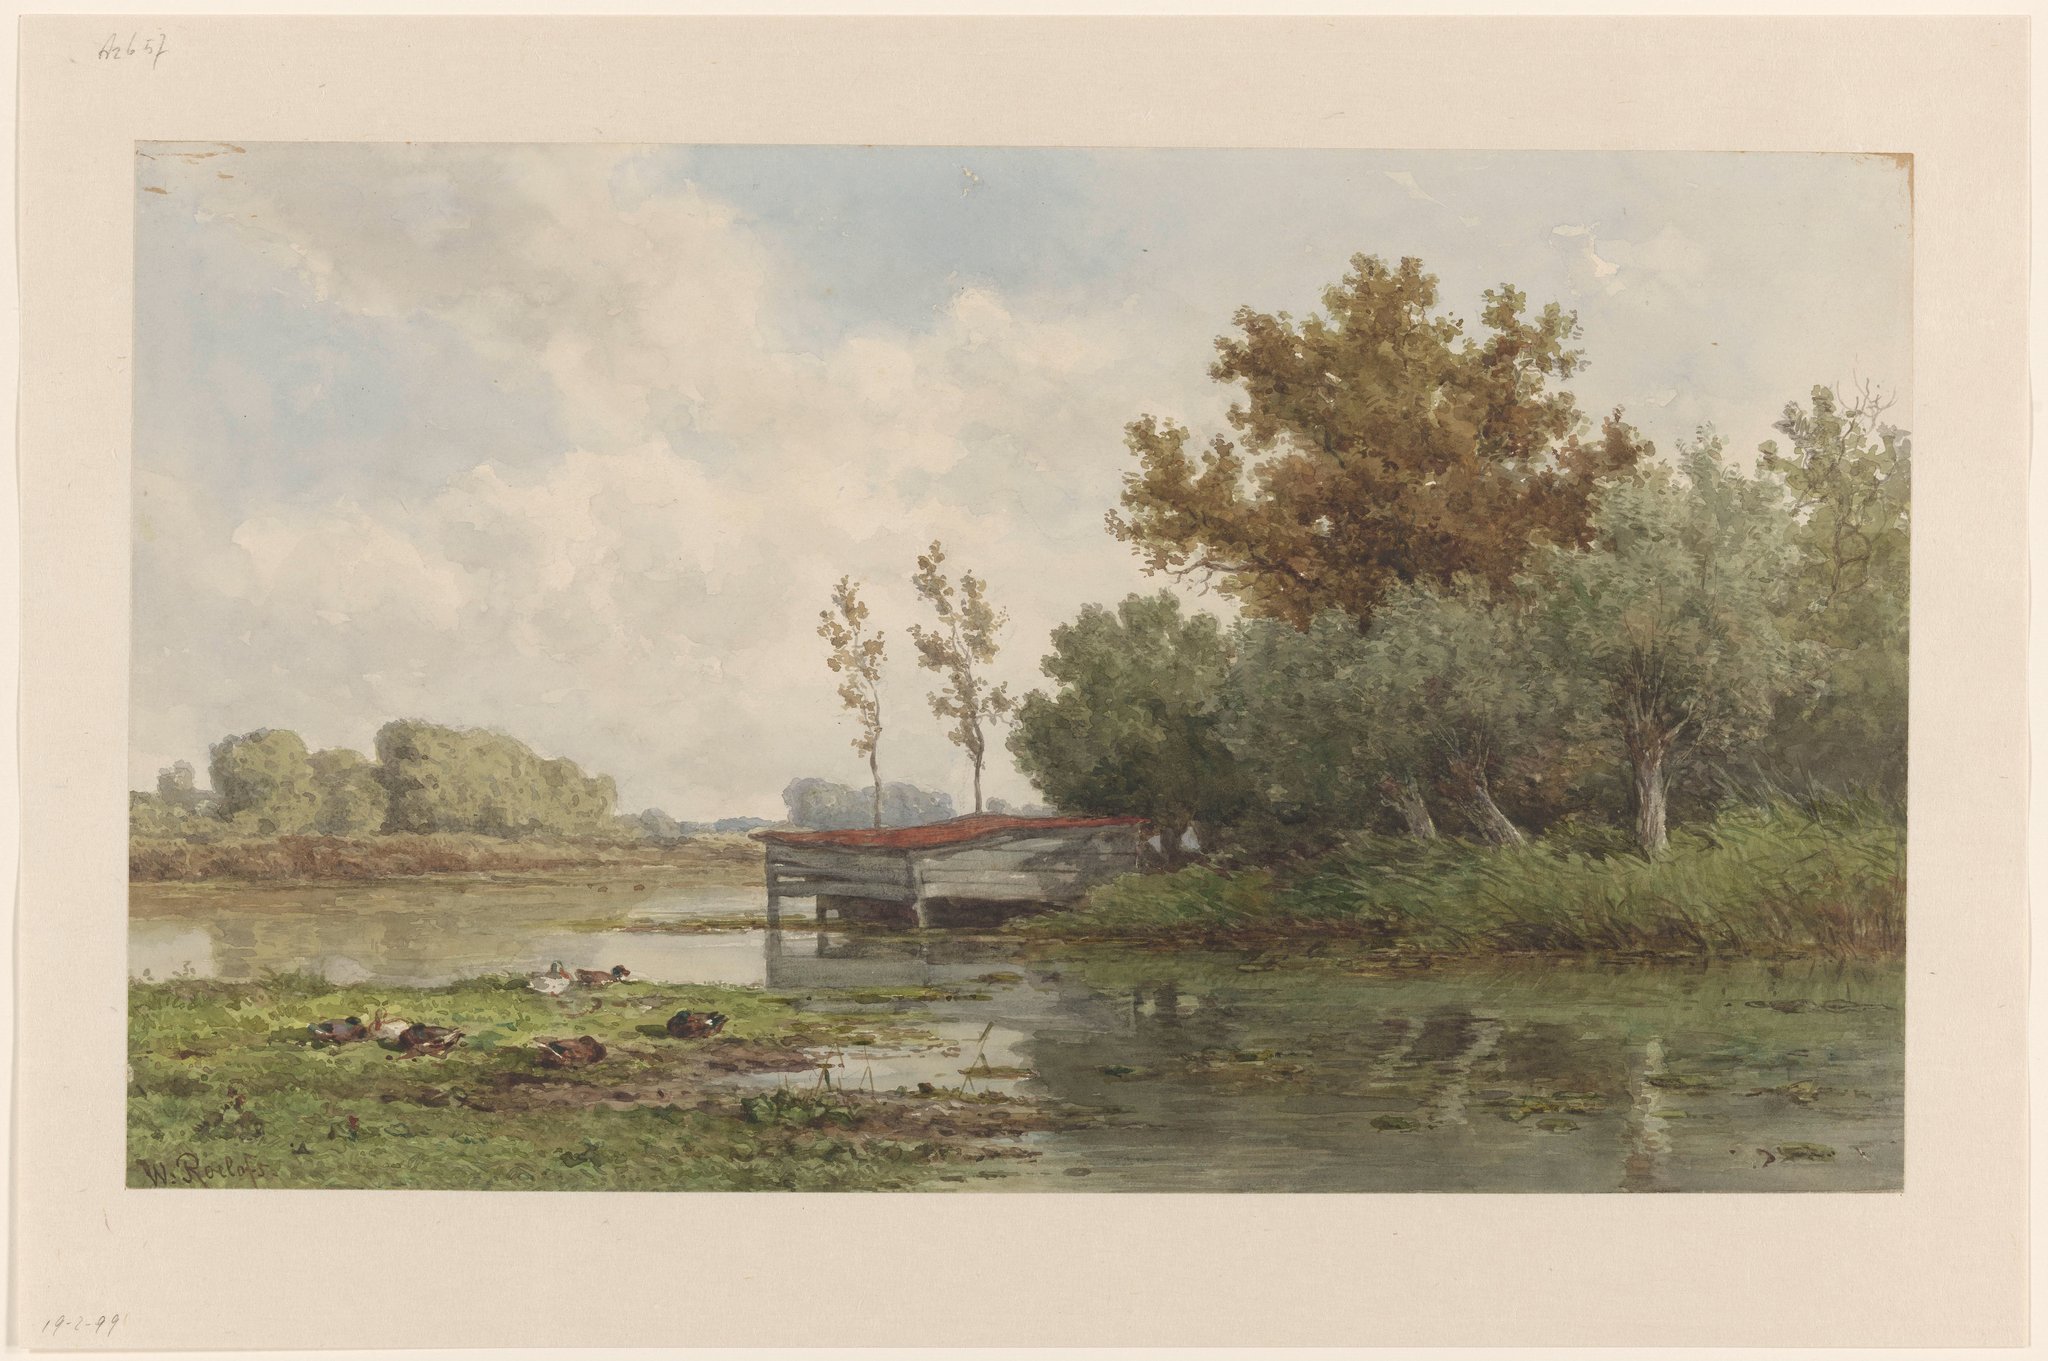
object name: watercolor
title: Landschap met water en eenden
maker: willem roelofs (i)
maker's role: draughtsman, painter, print maker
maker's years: 1822-1897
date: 1832-1892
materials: paper, watercolor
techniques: brush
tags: landscapes with waters, waterscapes, seascapes (in the temperate zone), water-birds: duck